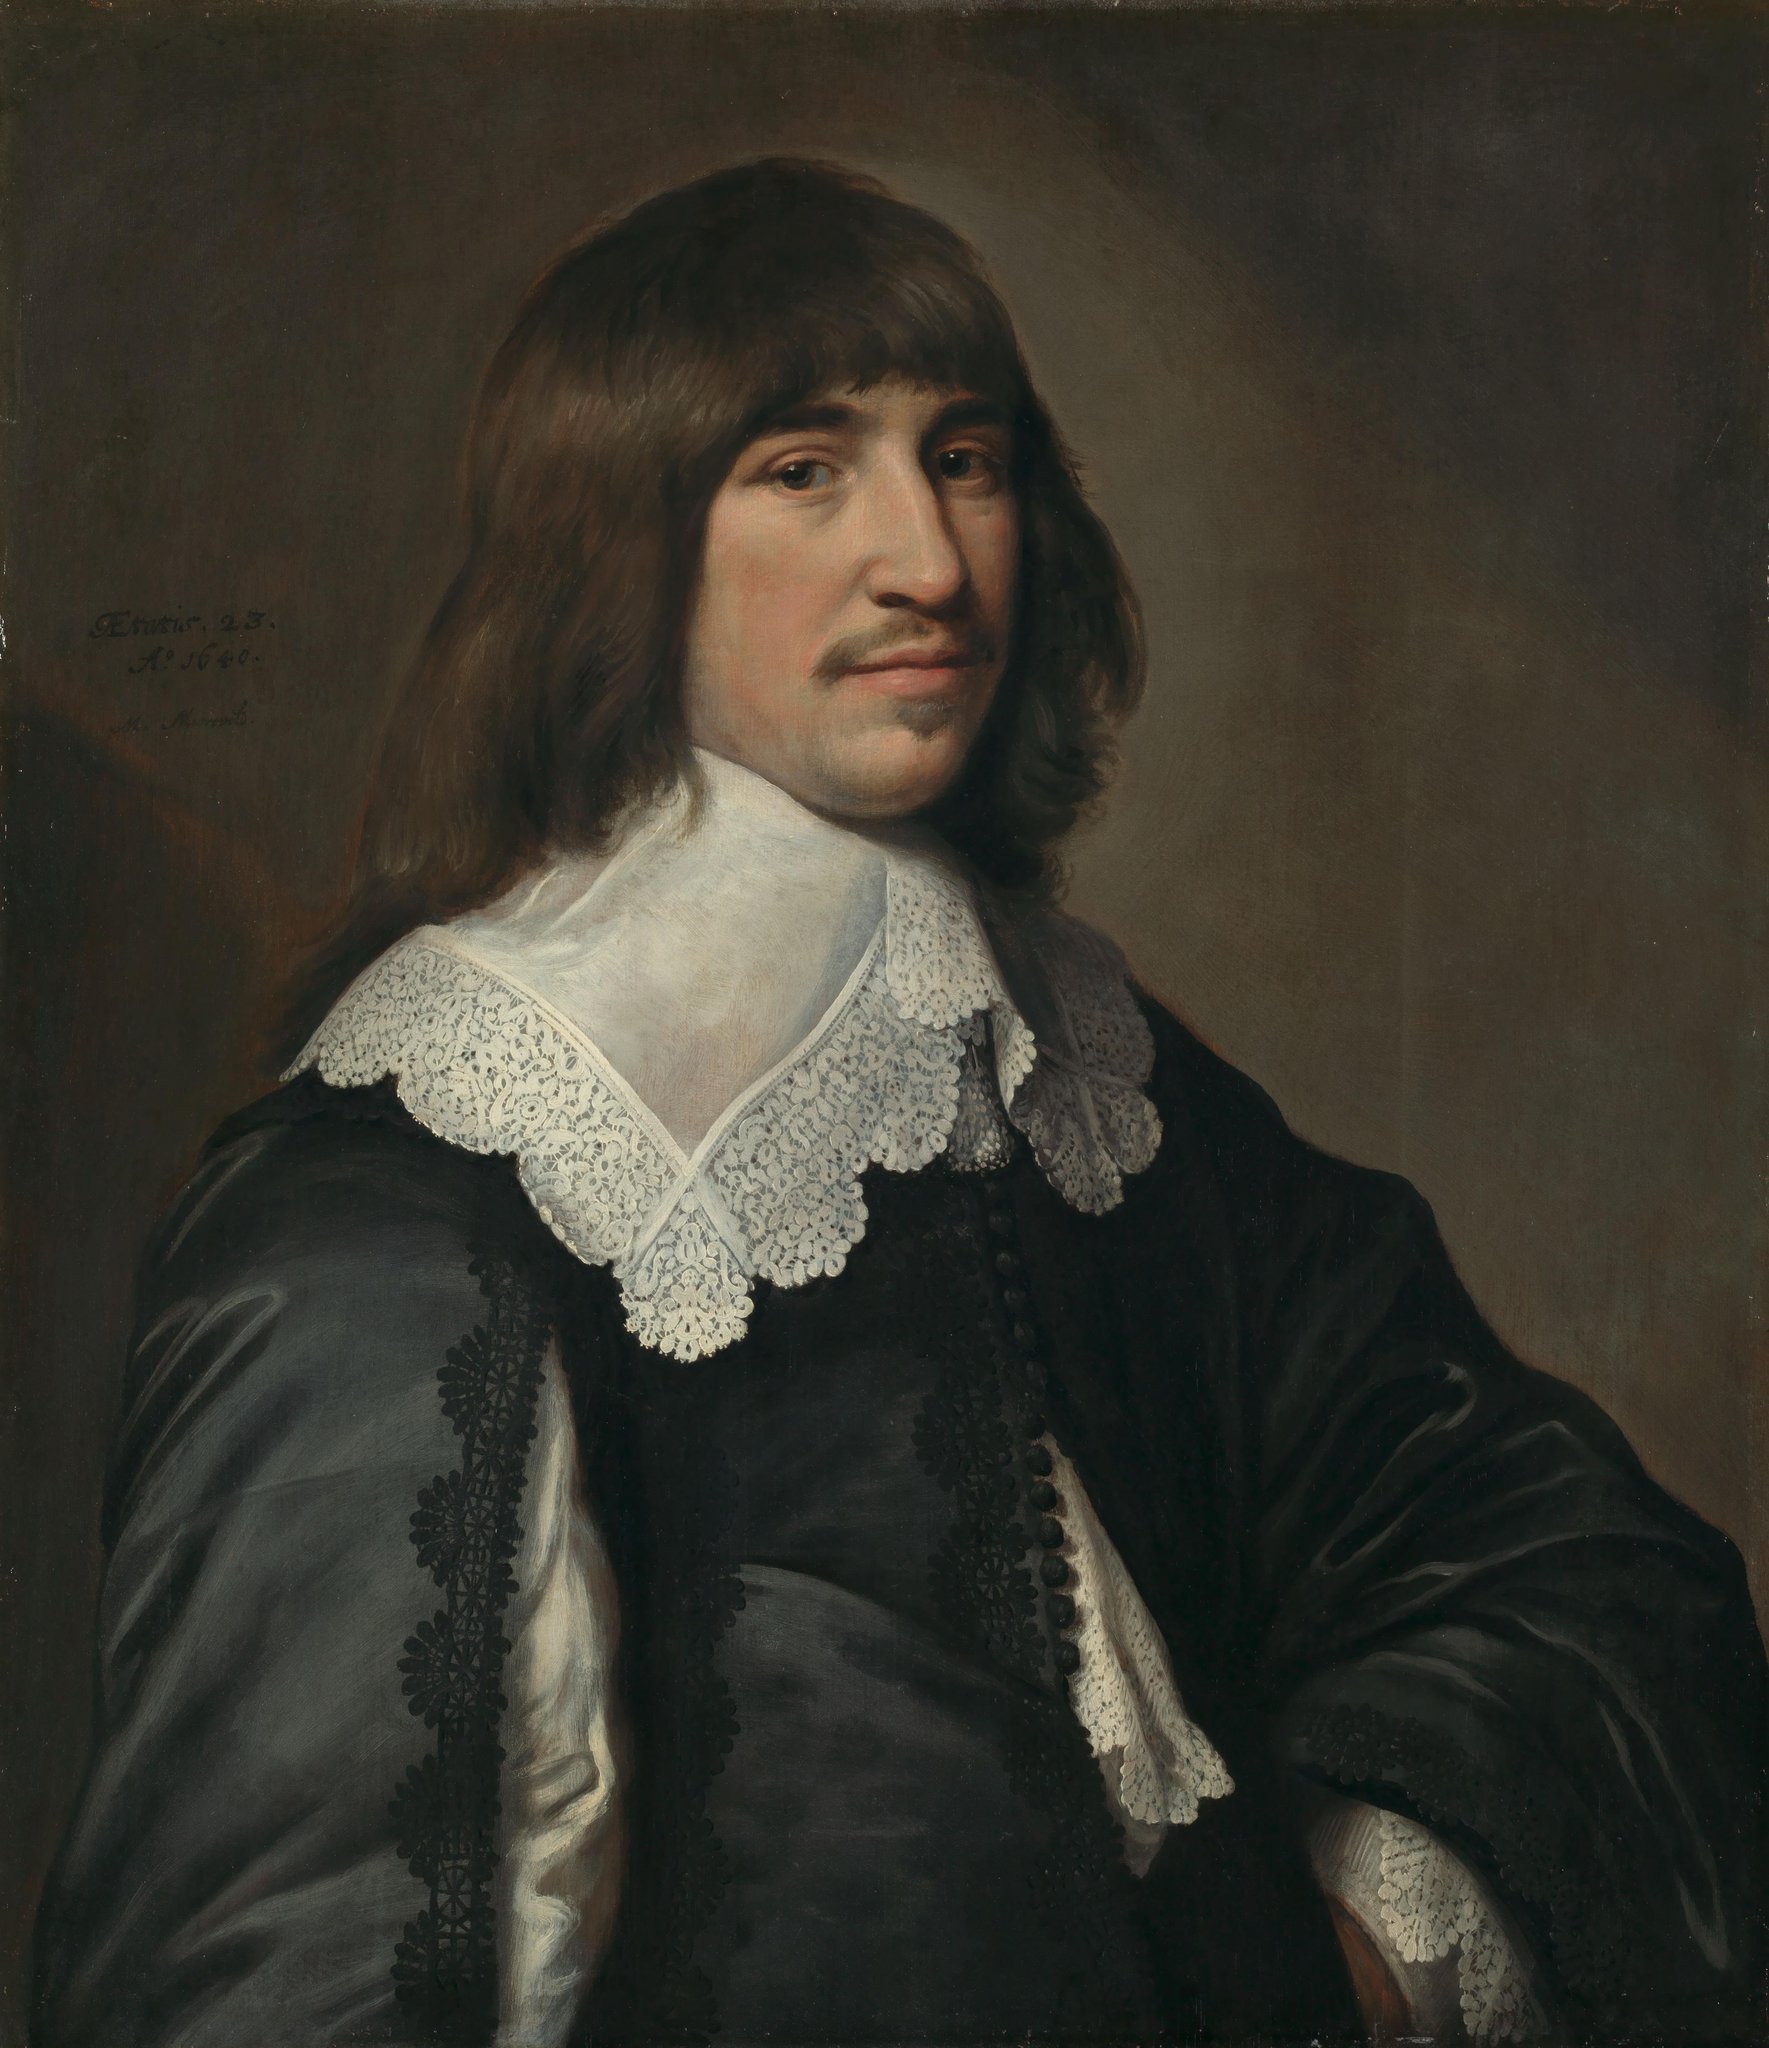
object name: painting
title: Portrait of Henrick Hooft (1617-78)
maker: michiel jansz van mierevelt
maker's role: draughtsman, painter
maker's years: 1567-1641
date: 1640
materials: oil, panel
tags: amsterdam, mayor, lace, historical persons (+ half-length portrait)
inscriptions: signature, date and inscription, centre left: ‘Ætatis. 23. / A.º 1640 / M. Miereveld’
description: The demand for portraits in the Netherlands was great in the 17th century. Michiel Jansz van Mierevelt was the most productive and successful portraitist in Delft: according to a somewhat exaggerated contemporary account, the artist painted around 10,000 portraits. His fame extended beyond the city limits. Both in their twenties, Henrick Hooft and Aegje Hasselaer of Amsterdam had themselves eternalized in paint by him on the occasion of their marriage.